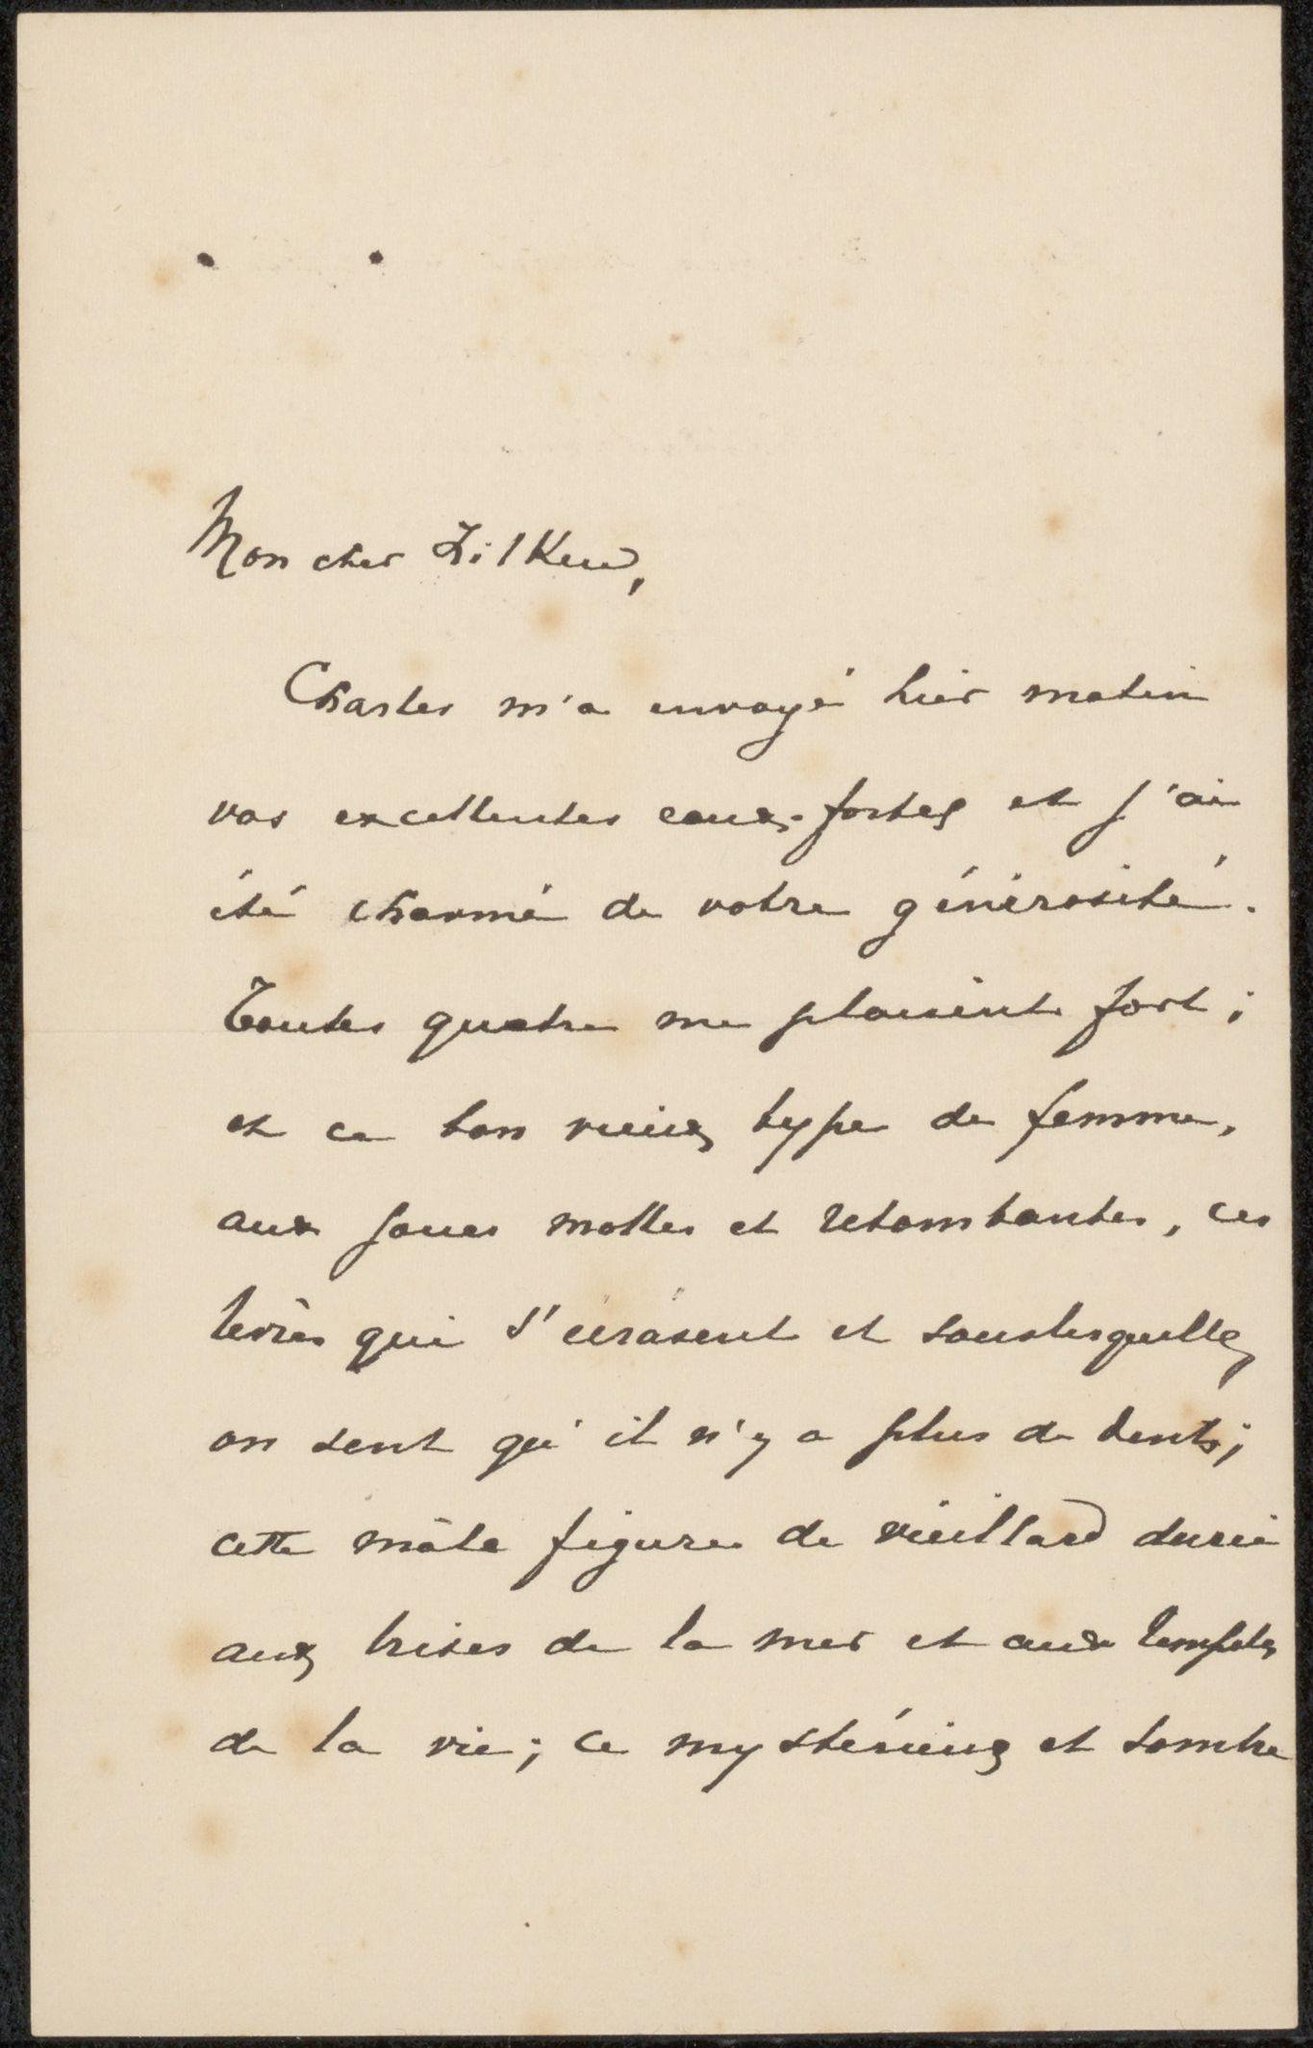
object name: letter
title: Brief aan Philip Zilcken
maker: jules destrée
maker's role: politician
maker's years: 1863-1936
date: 1873-1930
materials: ink, paper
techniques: pen, writing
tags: painter, draughtsman, edmond de goncourt, charles destrée, philip zilcken, the graphic arts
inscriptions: collector's mark: ‘RPK’